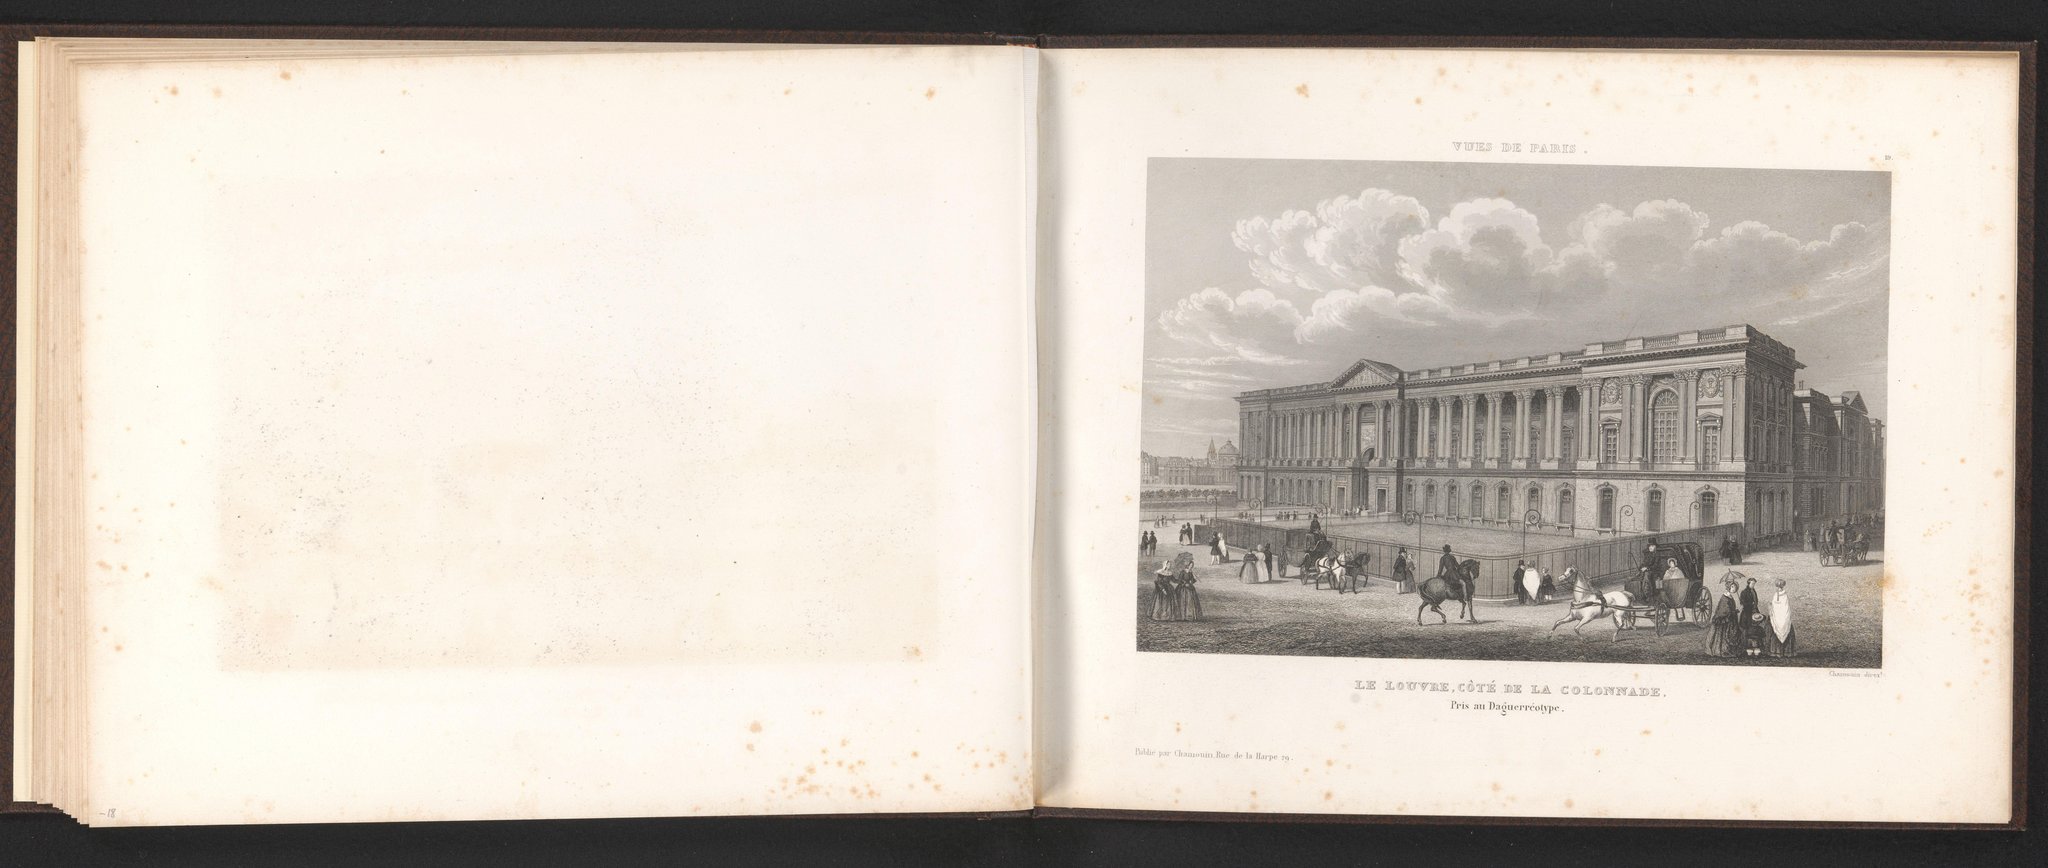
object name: print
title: Gezicht op het Palais du Louvre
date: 1845-1850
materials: paper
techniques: engraving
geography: paris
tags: palace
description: Prent op negentiende ongenummerde pagina na titelpagina. Prent gemaakt naar daguerreotypie.